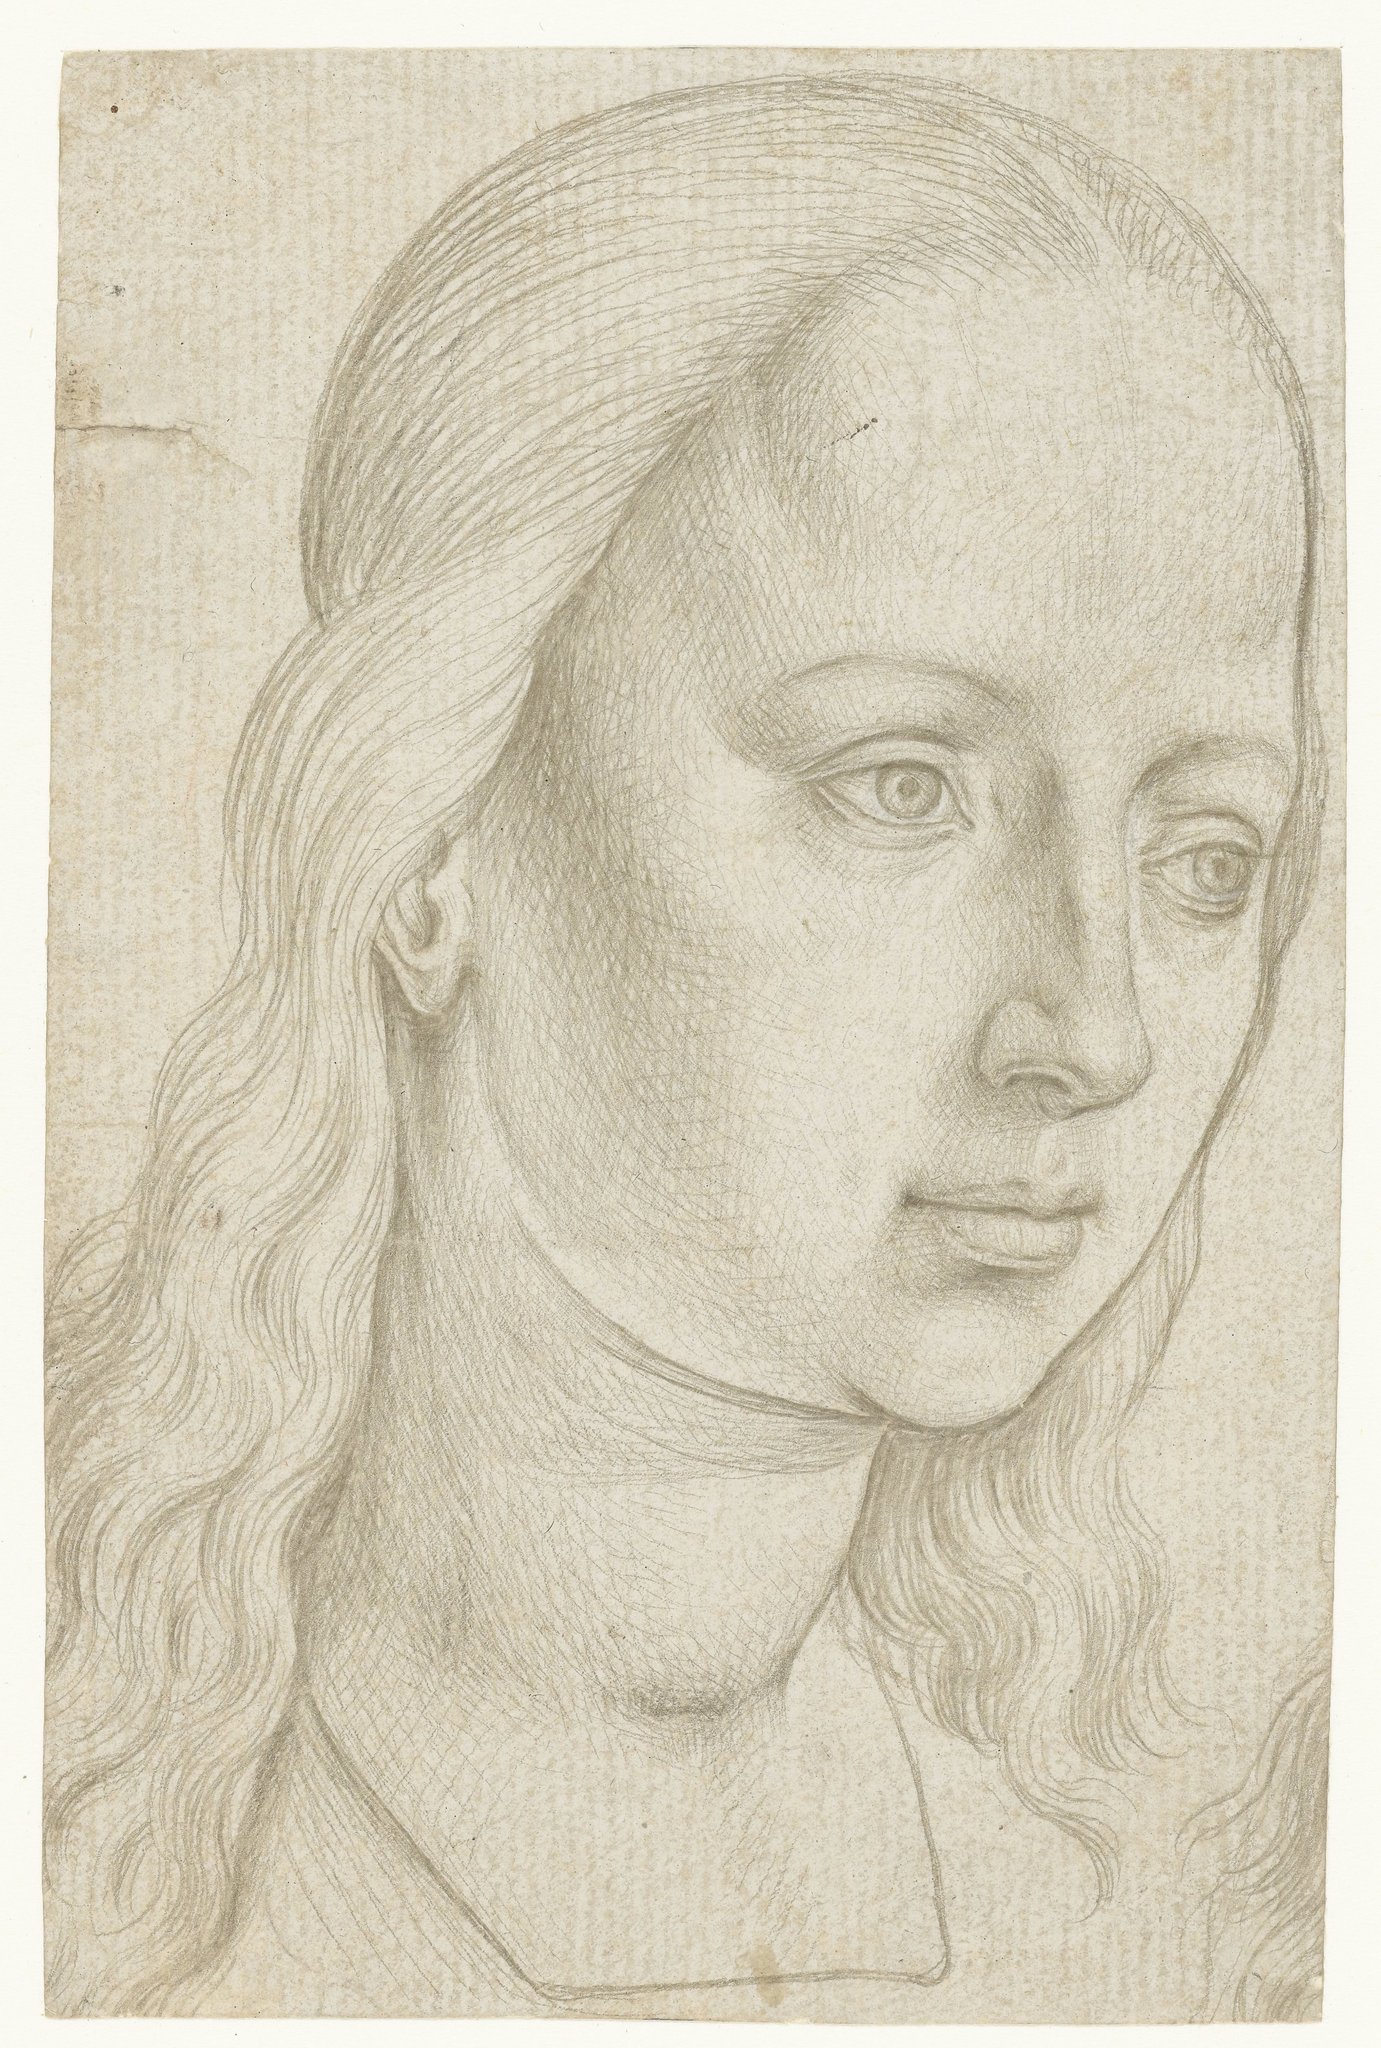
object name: drawing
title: Hoofd van een vrouwelijke heilige of van Maria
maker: hugo van der goes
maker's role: draughtsman, painter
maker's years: 1440-1482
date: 1440-1478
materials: paper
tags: 'portraits' of mary, female saints